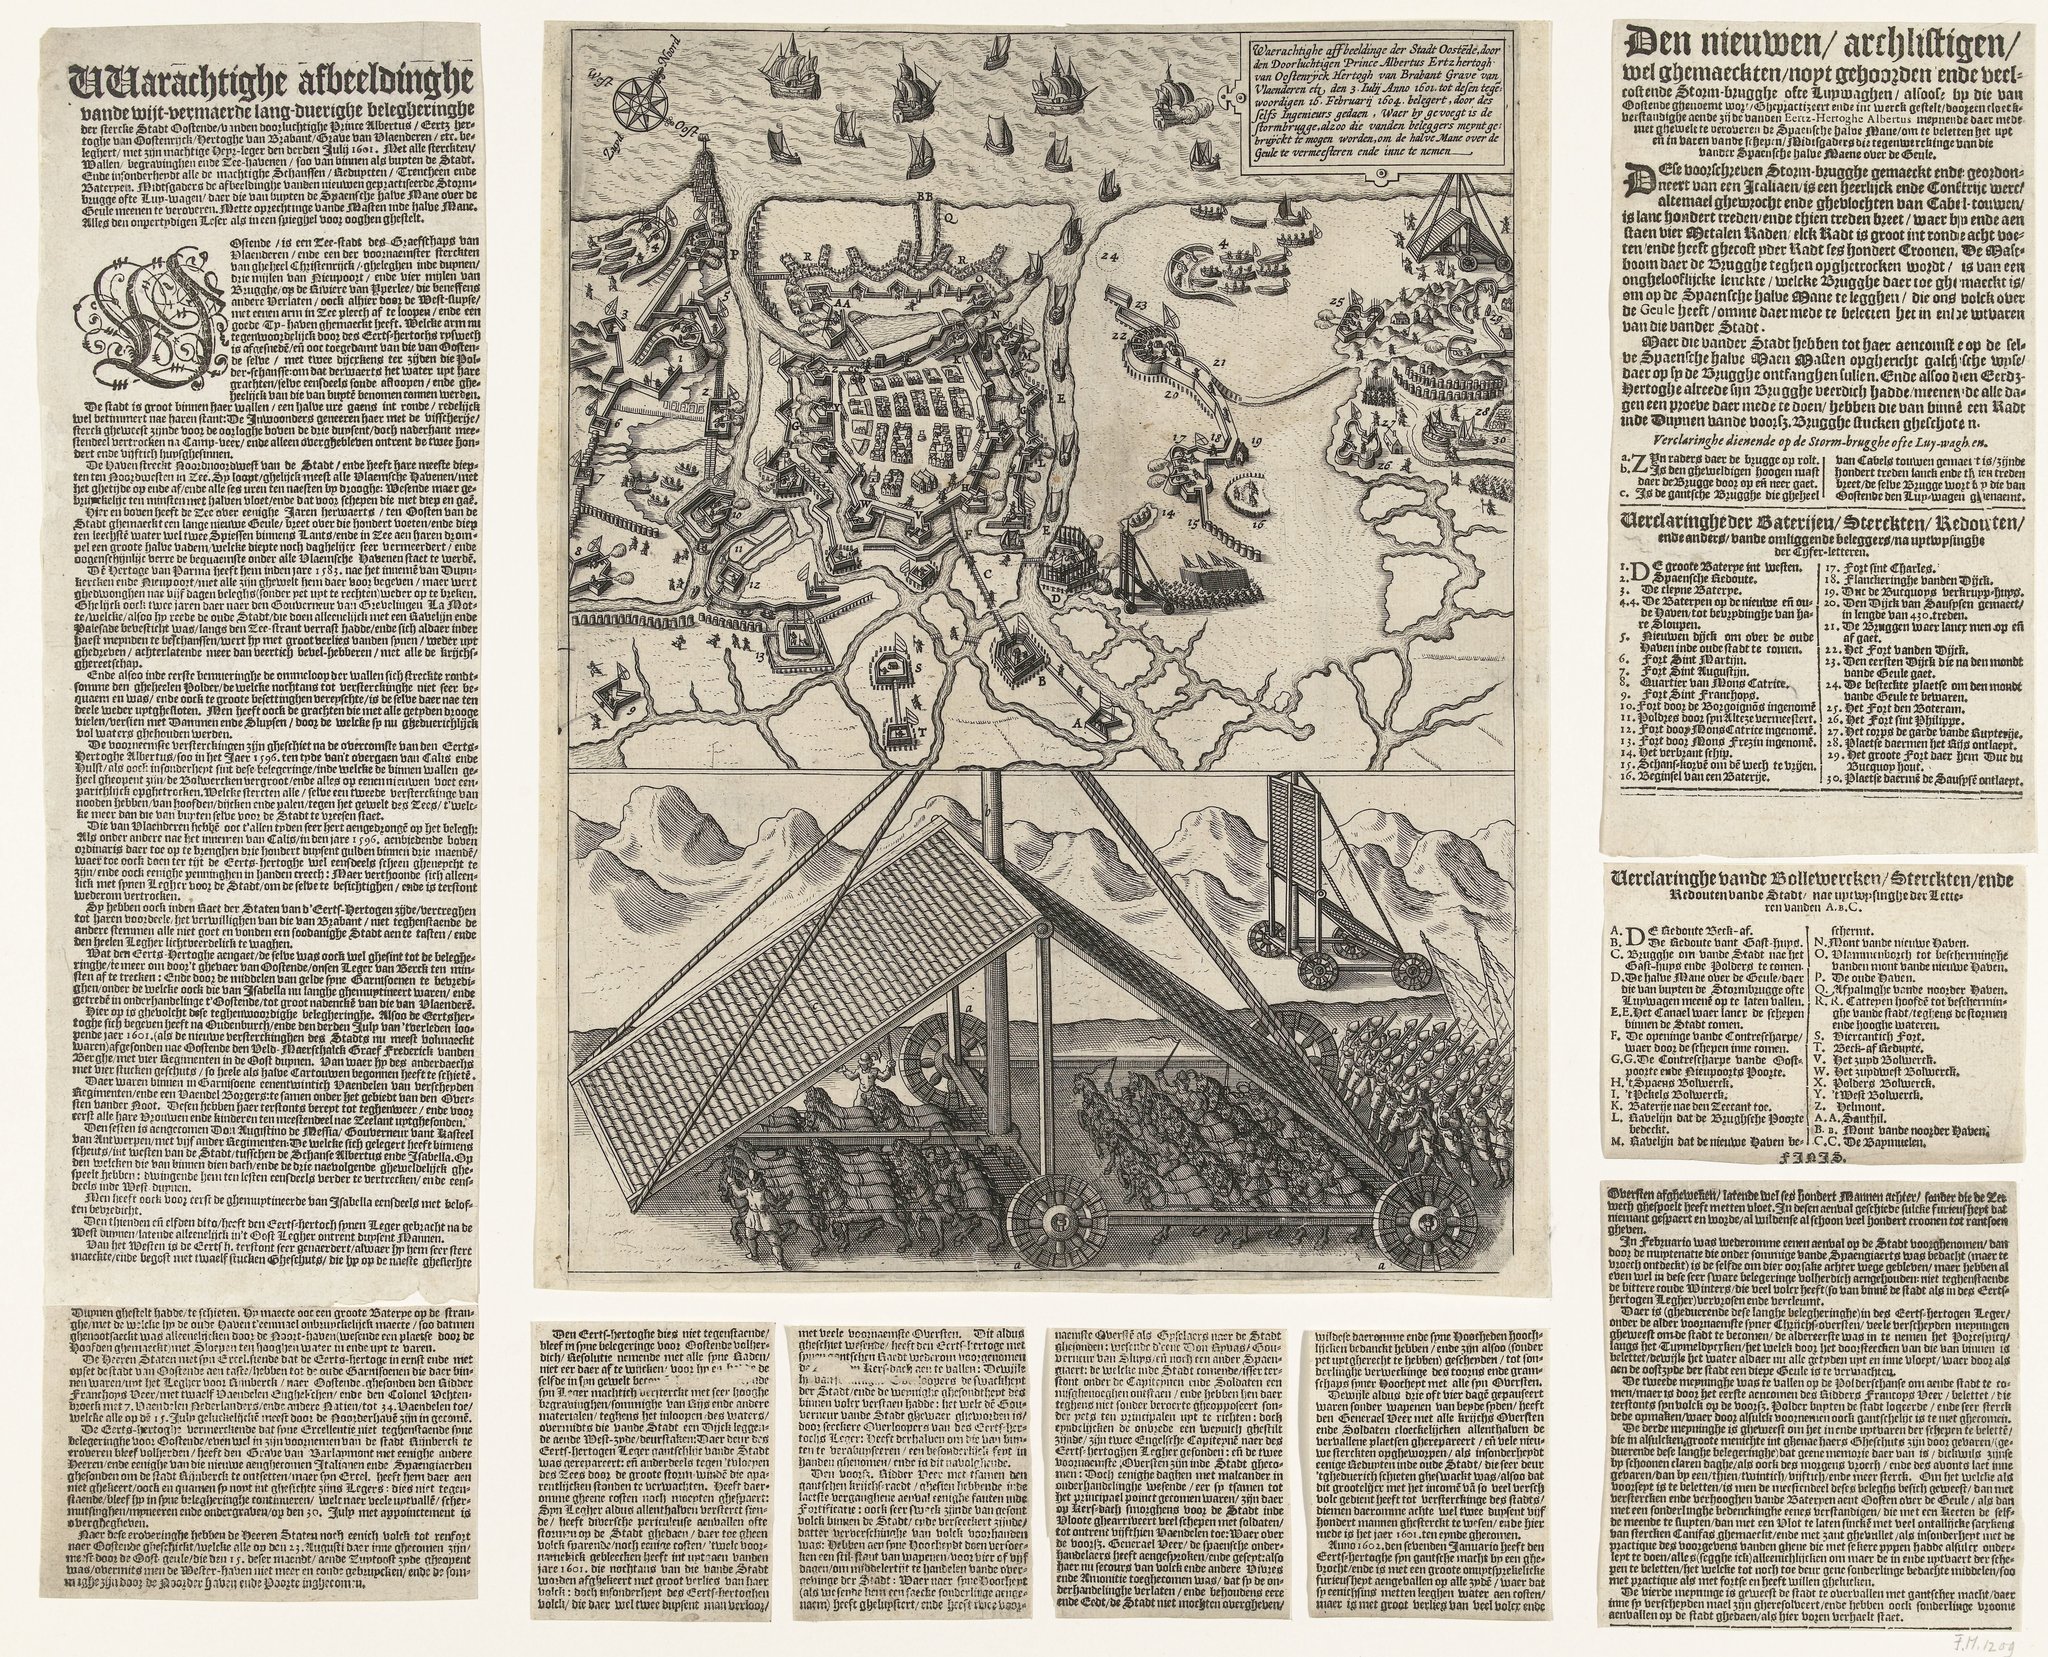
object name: print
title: Waerachtighe affbeeldinge der Stadt Ooste[n]de, door den Doorluchtigen Prince Albertus Ertzhertogh van Oostenrijck (...) den 3. Julij Anno 1601. tot desen tege[n]woordigen 16. Februarij 1604. belegert (...)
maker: Anonymous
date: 1604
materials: paper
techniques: engraving, etching, letterpress printing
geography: low countries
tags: engineer, pompeo targone, protective weapons, siege, position war, siege arms, e.g.: battering ram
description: Beleg van de stad Oostende in Staatse handen, door het Spaanse leger onder aartshertog Albrecht en later onder Spinola van 1601-1604. De centrale voorstelling toont de stand van zaken van het beleg in februari 1604. Centraal een voorstelling in twee delen, met bovenaan een kaart van Oostende en omgeving met de posities van de belegerende troepen; onderaan de door paarden voortgetrokken stormbrug uitgevonden door Targone. Ongemonteerd geheel bestaande uit een prent met 9 losse tekstdelen met beschrijvingen van de gebeurtenissen en de stormbrug, met de legenda's a-c, 1-30 en A-C.C. in het Nederlands.